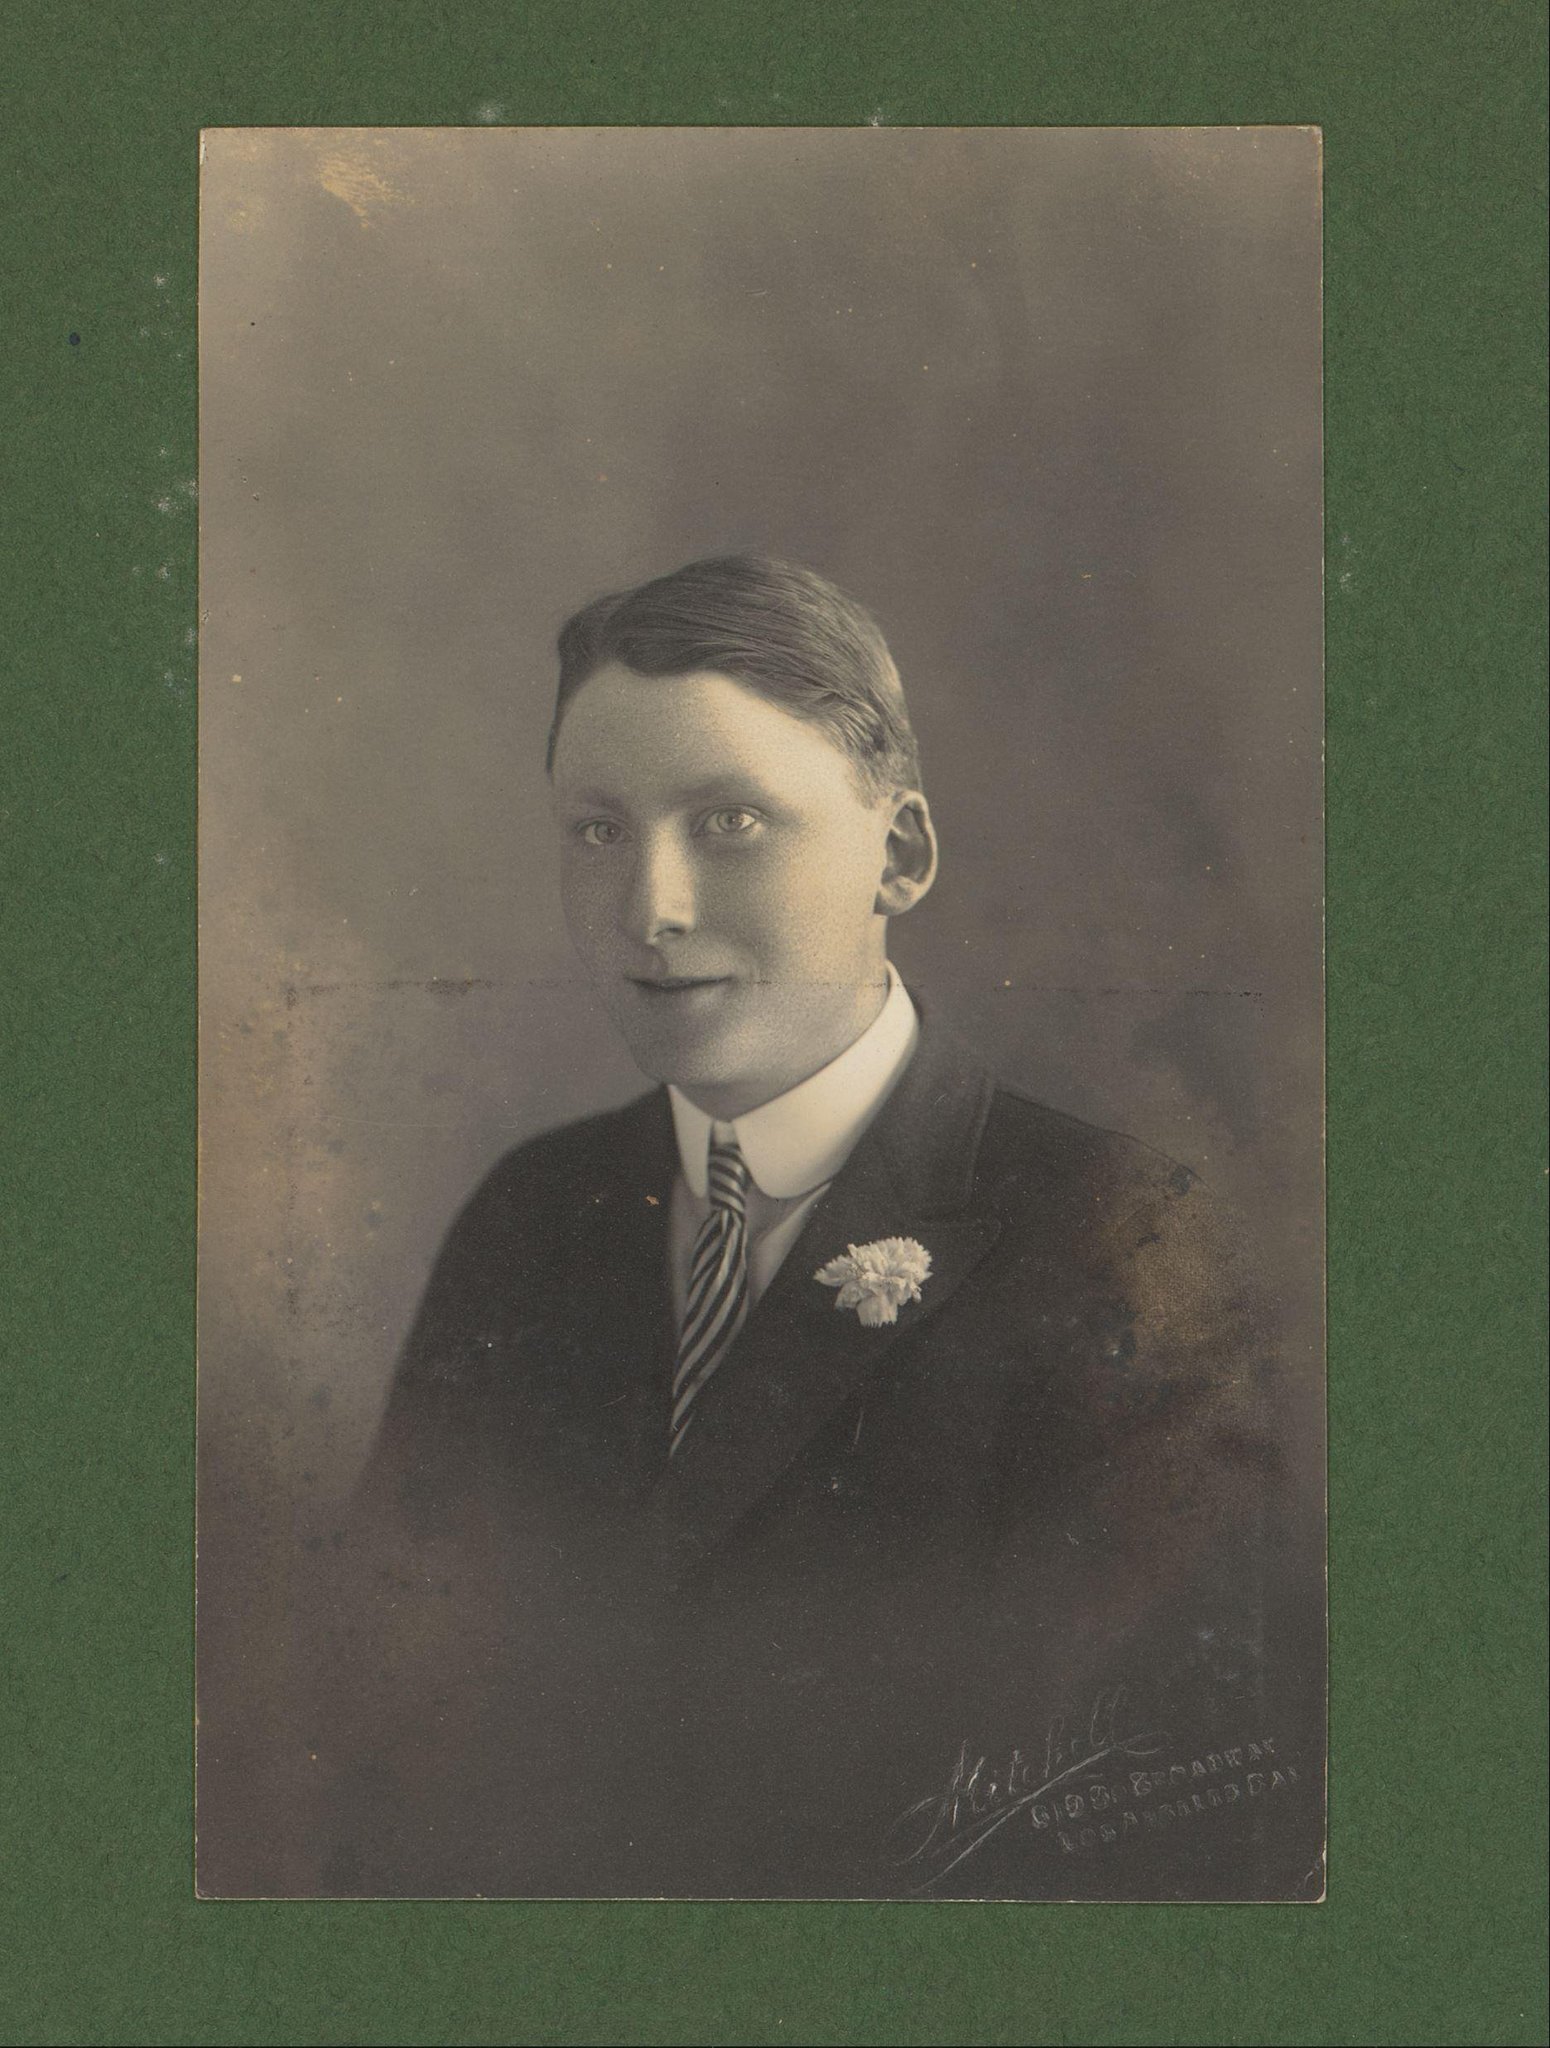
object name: album leaf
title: Portret van een man in pak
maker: mitchell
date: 1900-1925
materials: photographic support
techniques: gelatin silver print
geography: los angeles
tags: adult woman